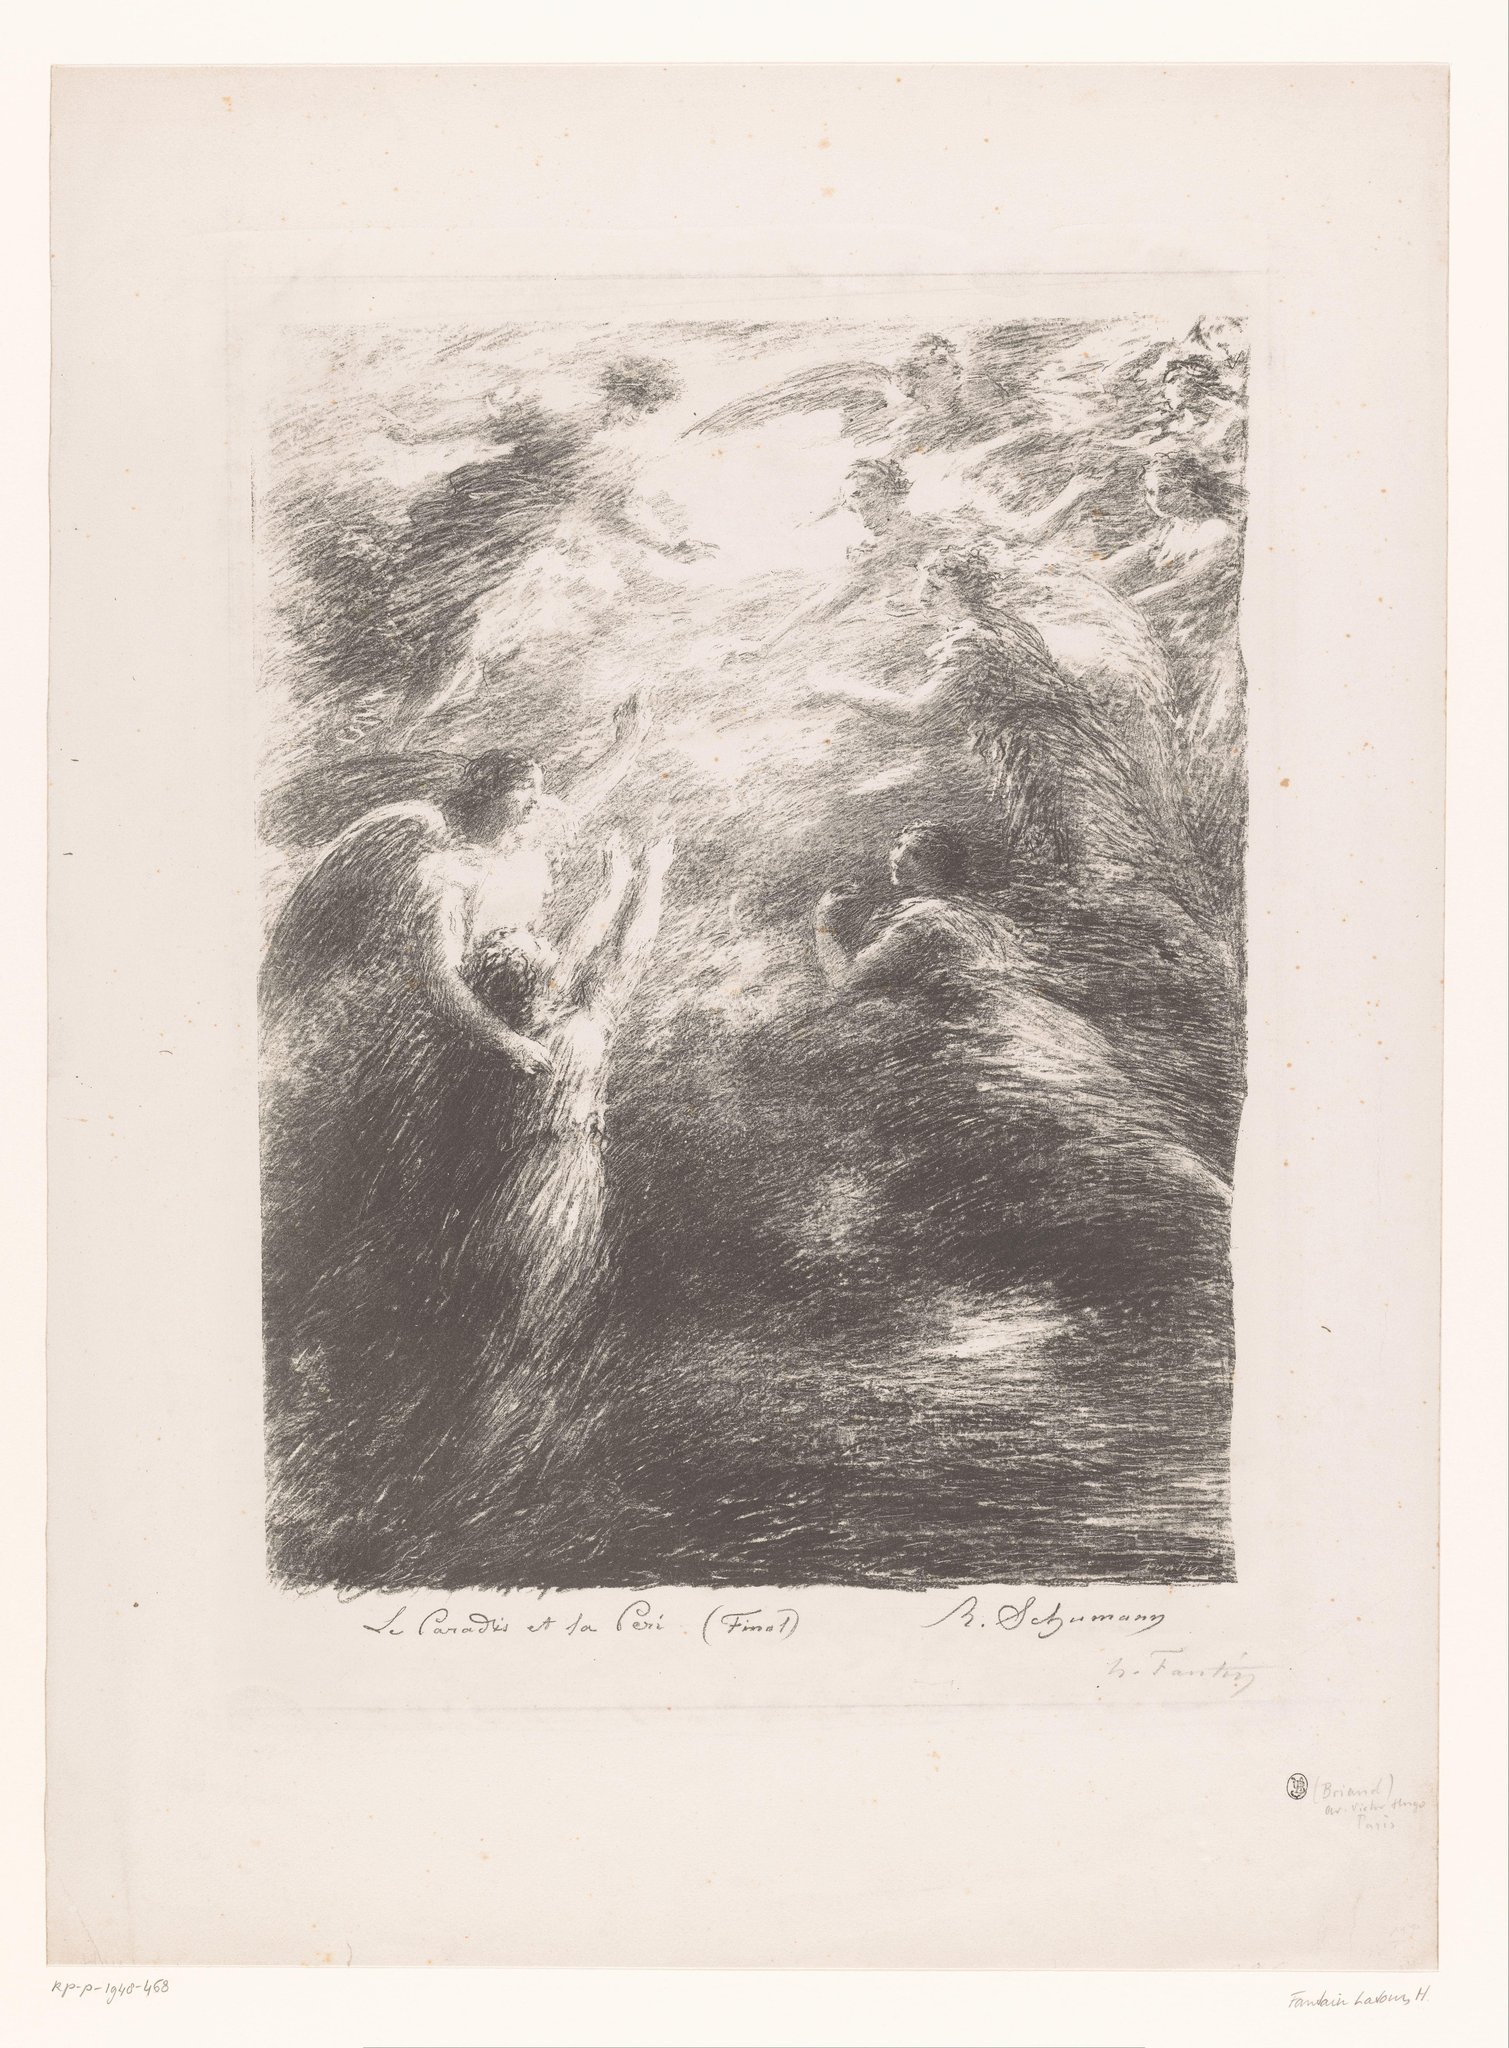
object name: print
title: Le Paradis et la Péri (Final), R. Schumann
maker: henri fantin-latour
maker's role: draughtsman, print maker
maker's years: 1836-1904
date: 1893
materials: paper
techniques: lithography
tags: ascending (movement in the air), activities of angels (in heaven)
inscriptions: stamp: Lugt 421, collector's mark: Lugt 2228a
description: Illustratie bij Das Paradies und die Peri, een oratorium van Robert Schumann.